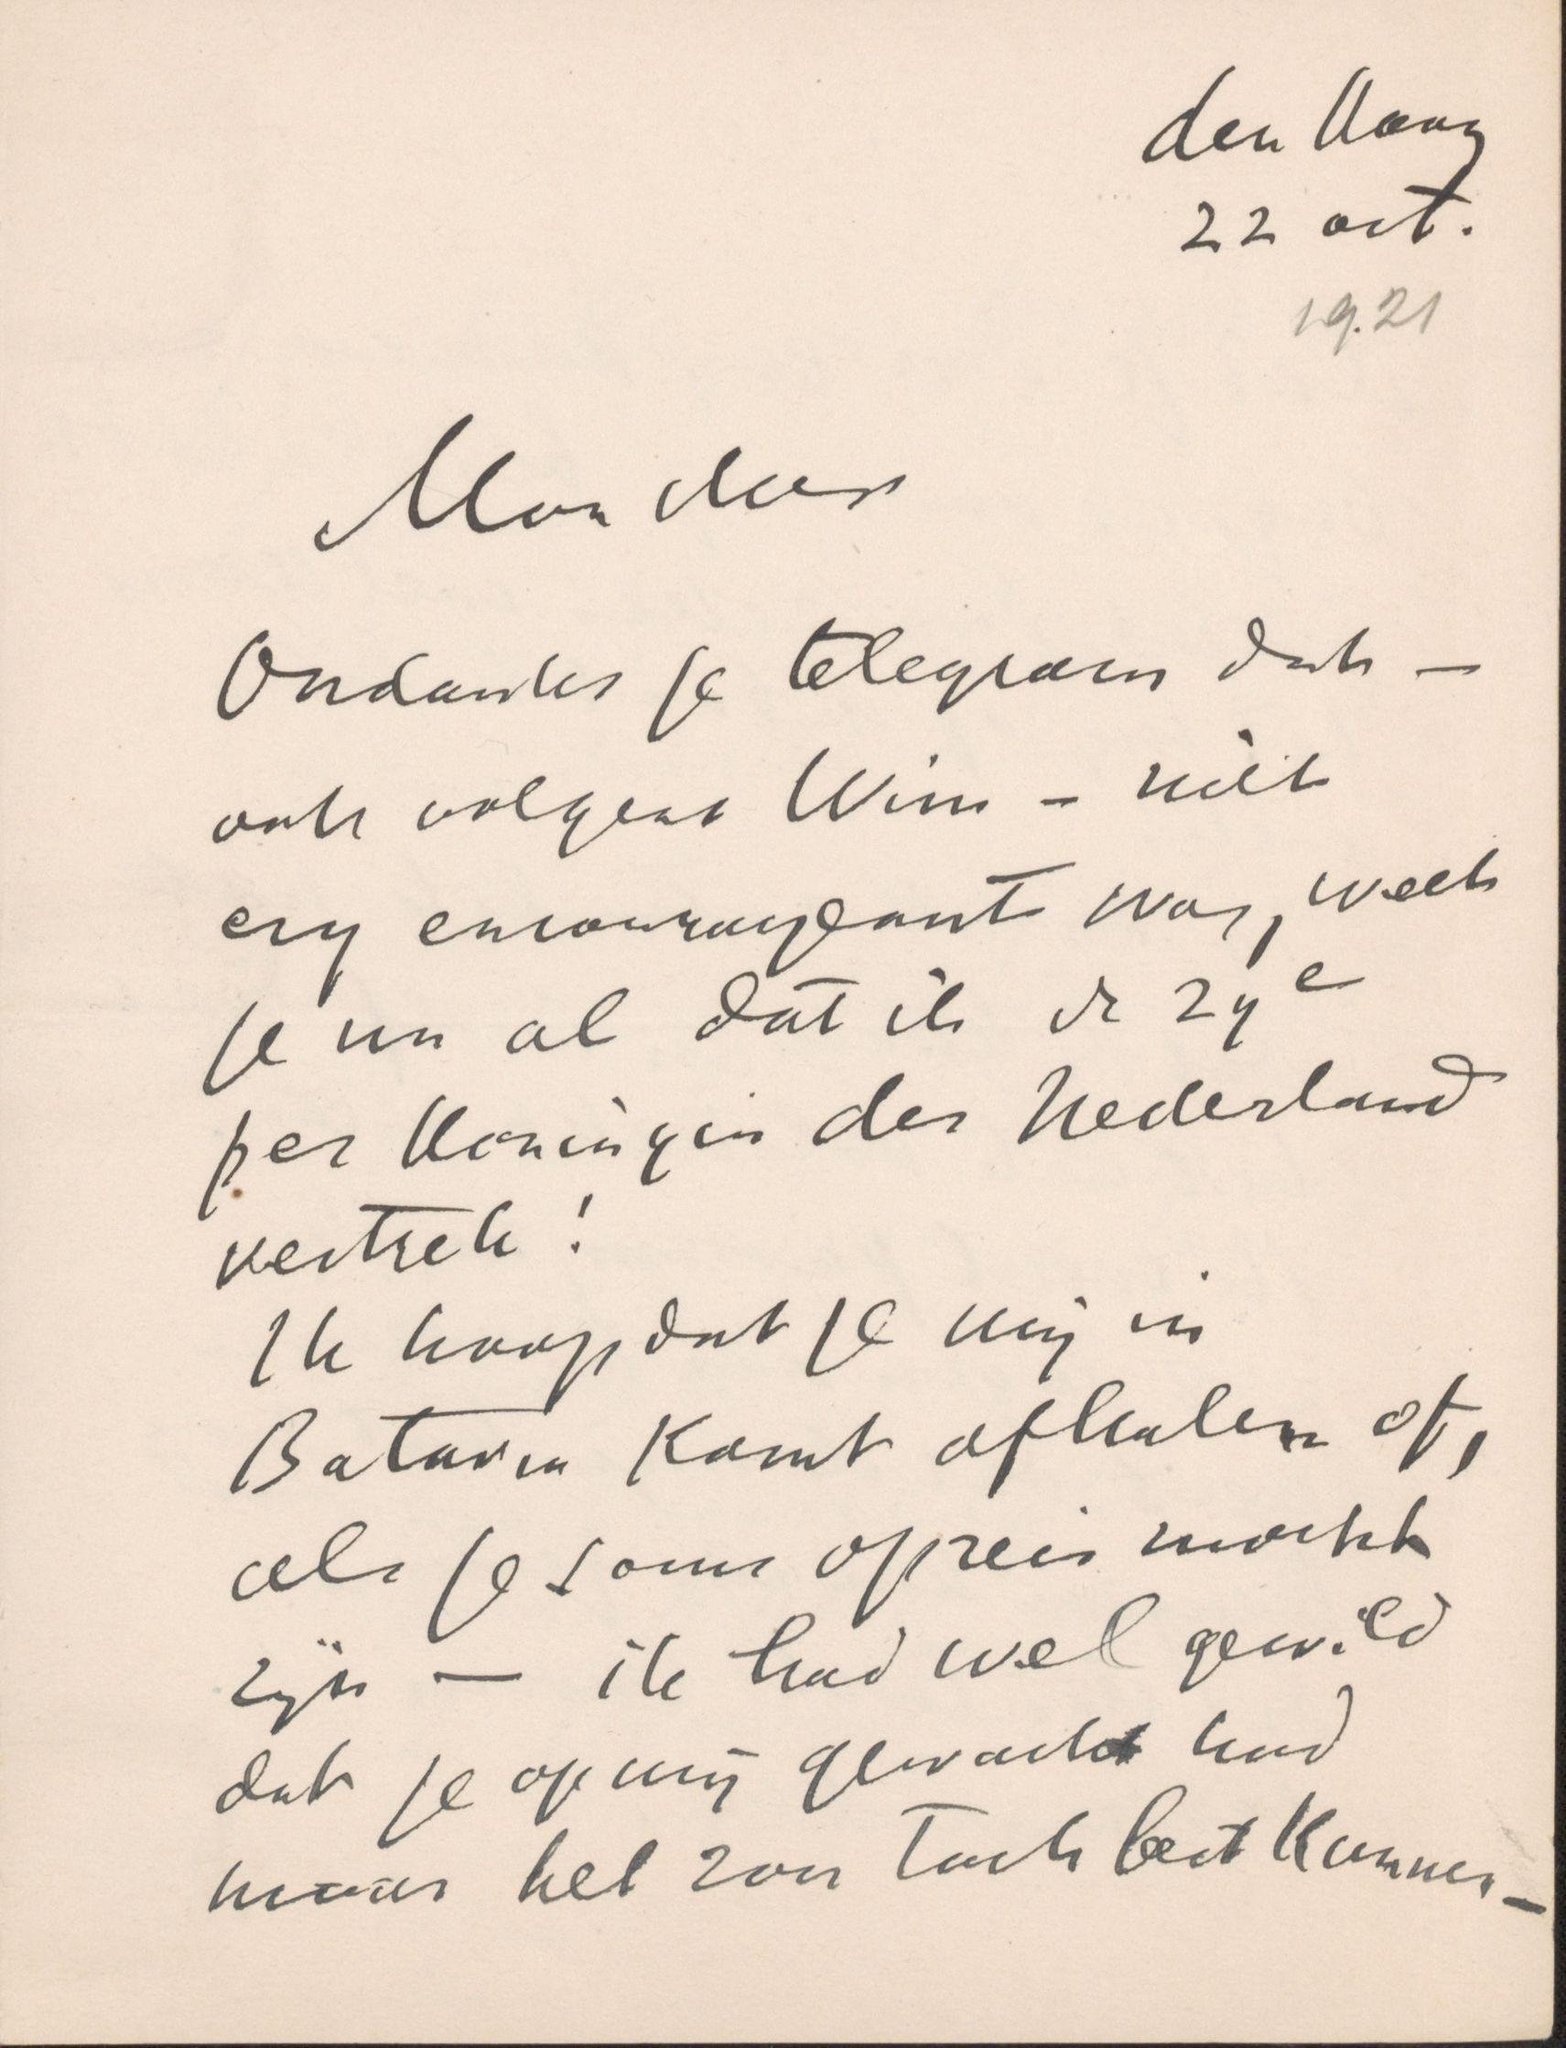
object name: letter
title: Brief aan Jan Veth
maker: isaac israels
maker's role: draughtsman, painter, print maker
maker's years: 1865-1934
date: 1875-1925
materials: ink, paper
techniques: pen, writing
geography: the hague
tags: dordrecht, designer, jan veth, willem witsen, travelling; tourism, batavia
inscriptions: collector's mark: ‘RPK’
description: Gedateerd 22 oktober. In latere hand 21.